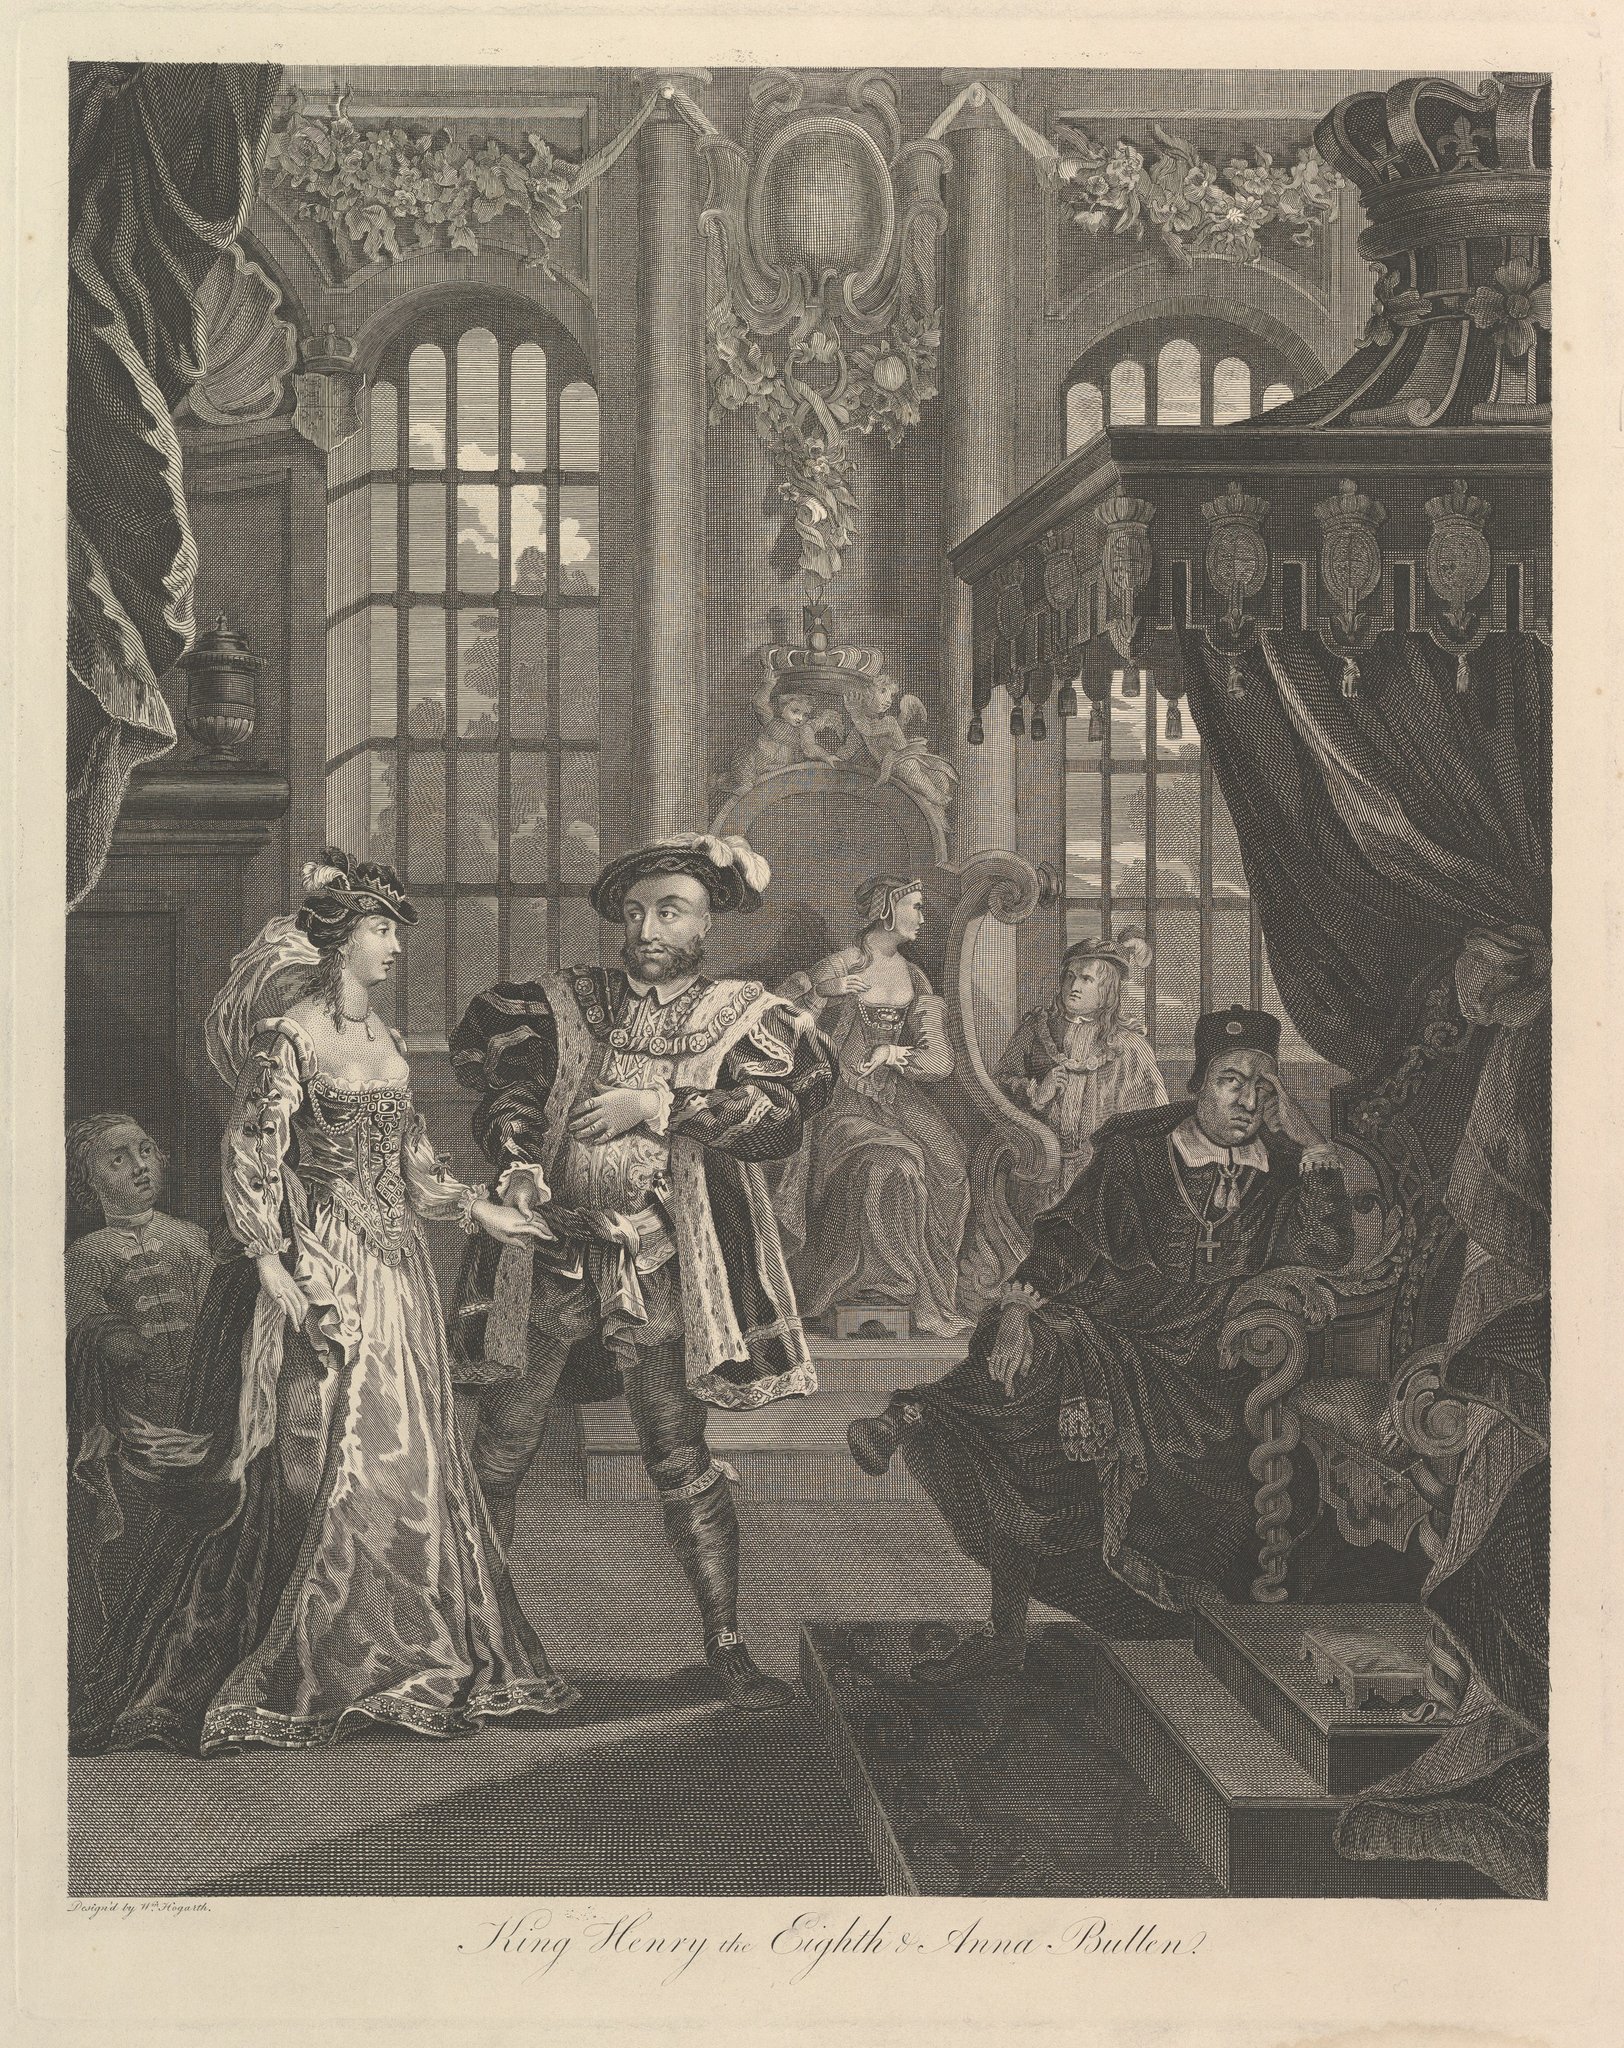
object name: print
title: King Henry the Eighth and Anna Bullen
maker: william hogarth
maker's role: artist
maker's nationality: british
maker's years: 1697-1764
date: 1801-1900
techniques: engraving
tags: interiors,henry viii,queens,men,women